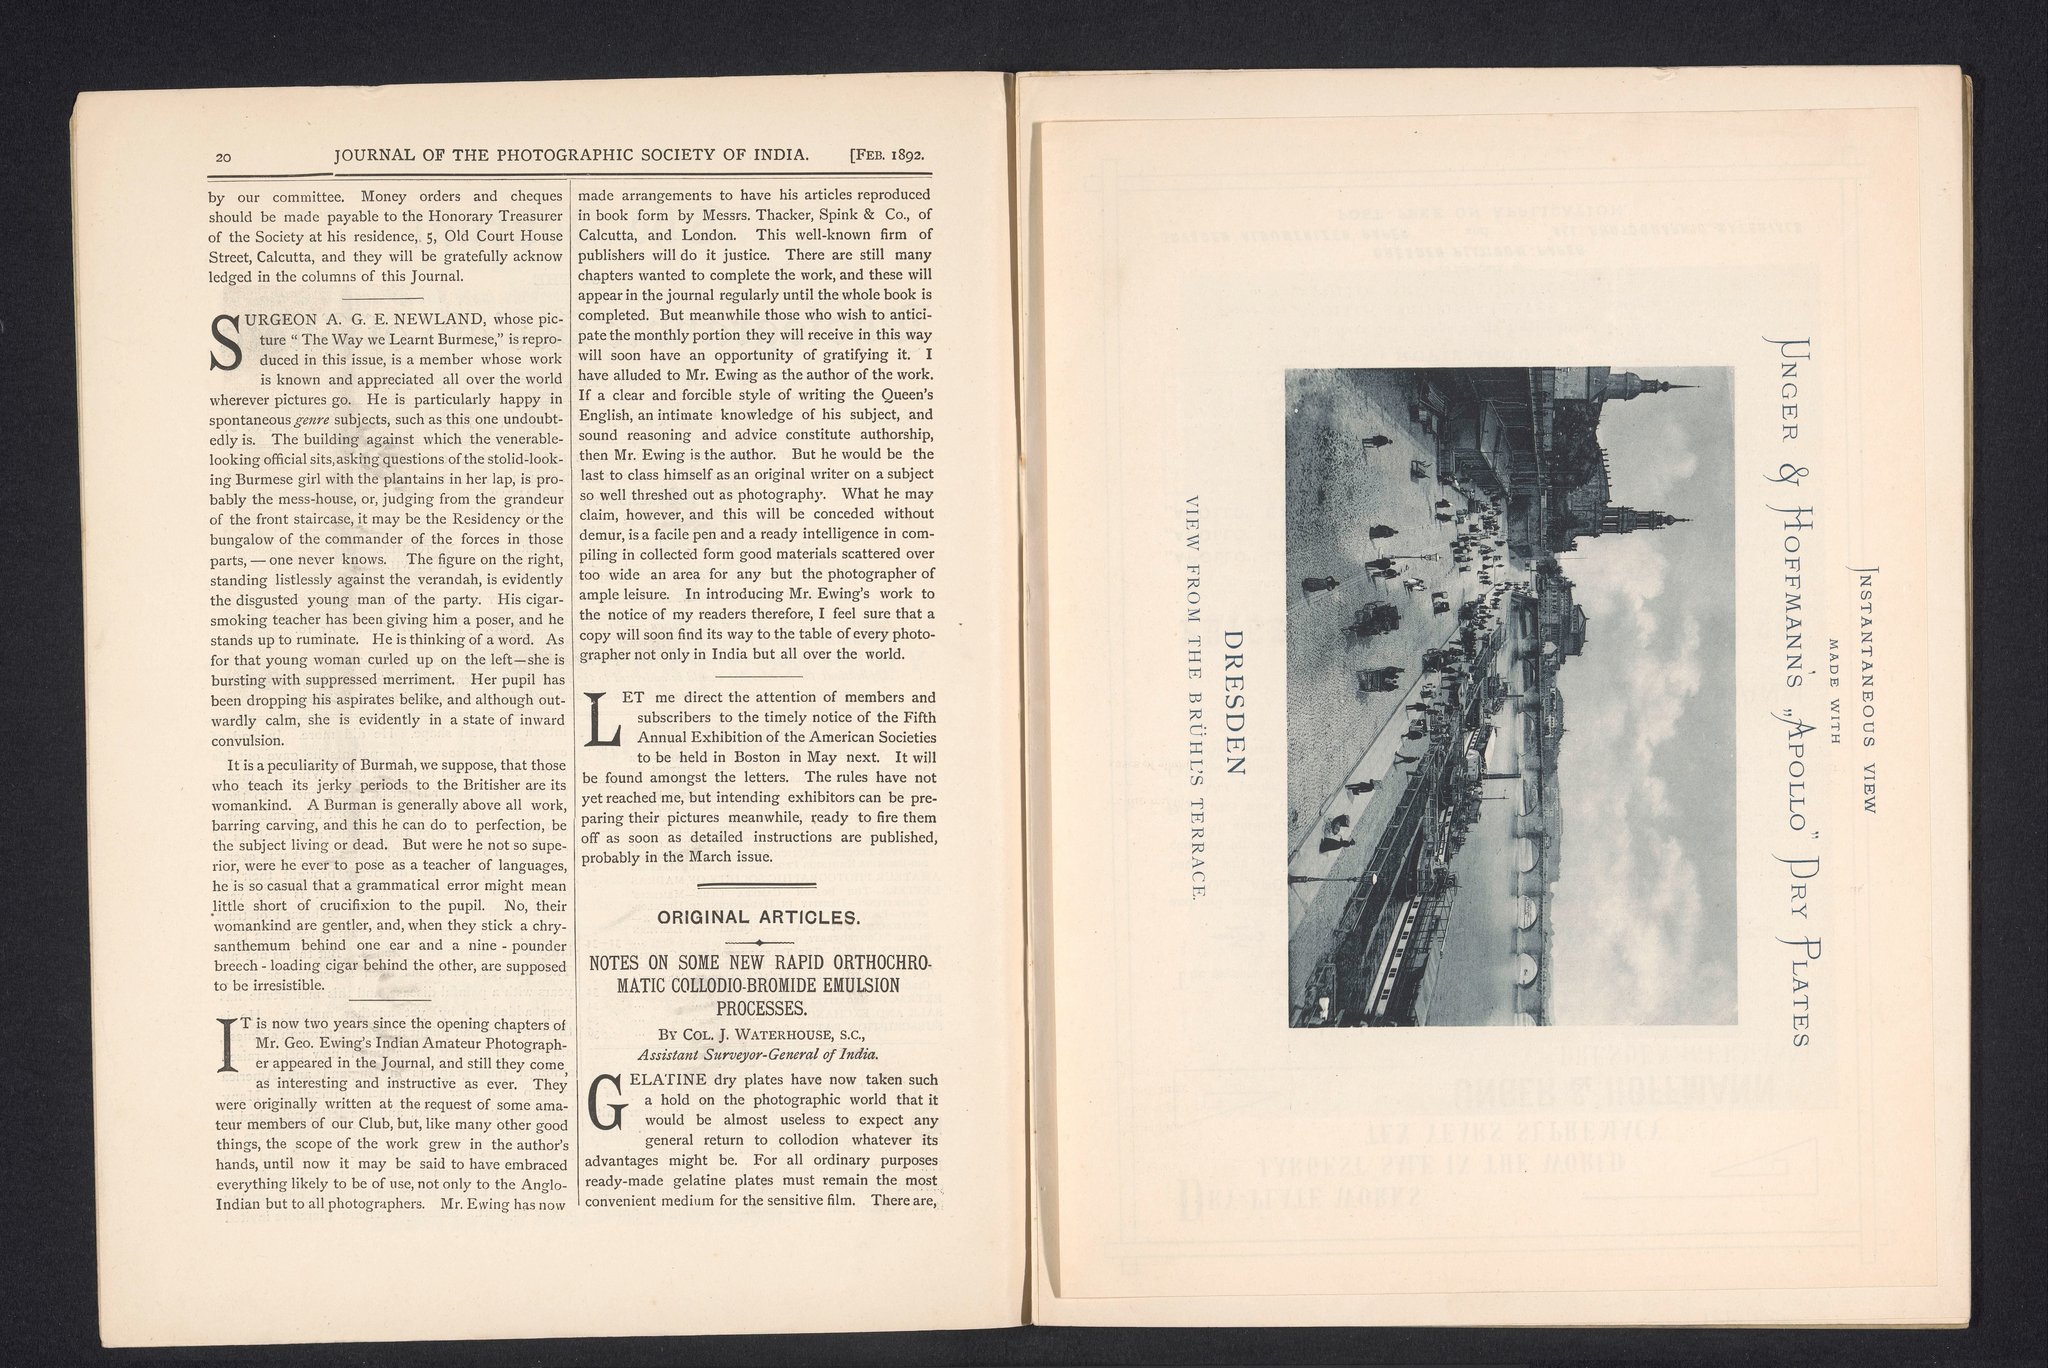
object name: photomechanical print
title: Dresden view from the Brühl's terrace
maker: Anonymous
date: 1892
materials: paper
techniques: photograph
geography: dresden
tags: bridge in city across river, canal, etc., street (+ city(-scape) with figures, staffage)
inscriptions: inscription: ‘Instantaneous view made with Unger & Hoffmann's ,,Apollo" Dry plates’, inscription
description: Het is een reclame voor negatiefplaten van Unger & Hoffmann.